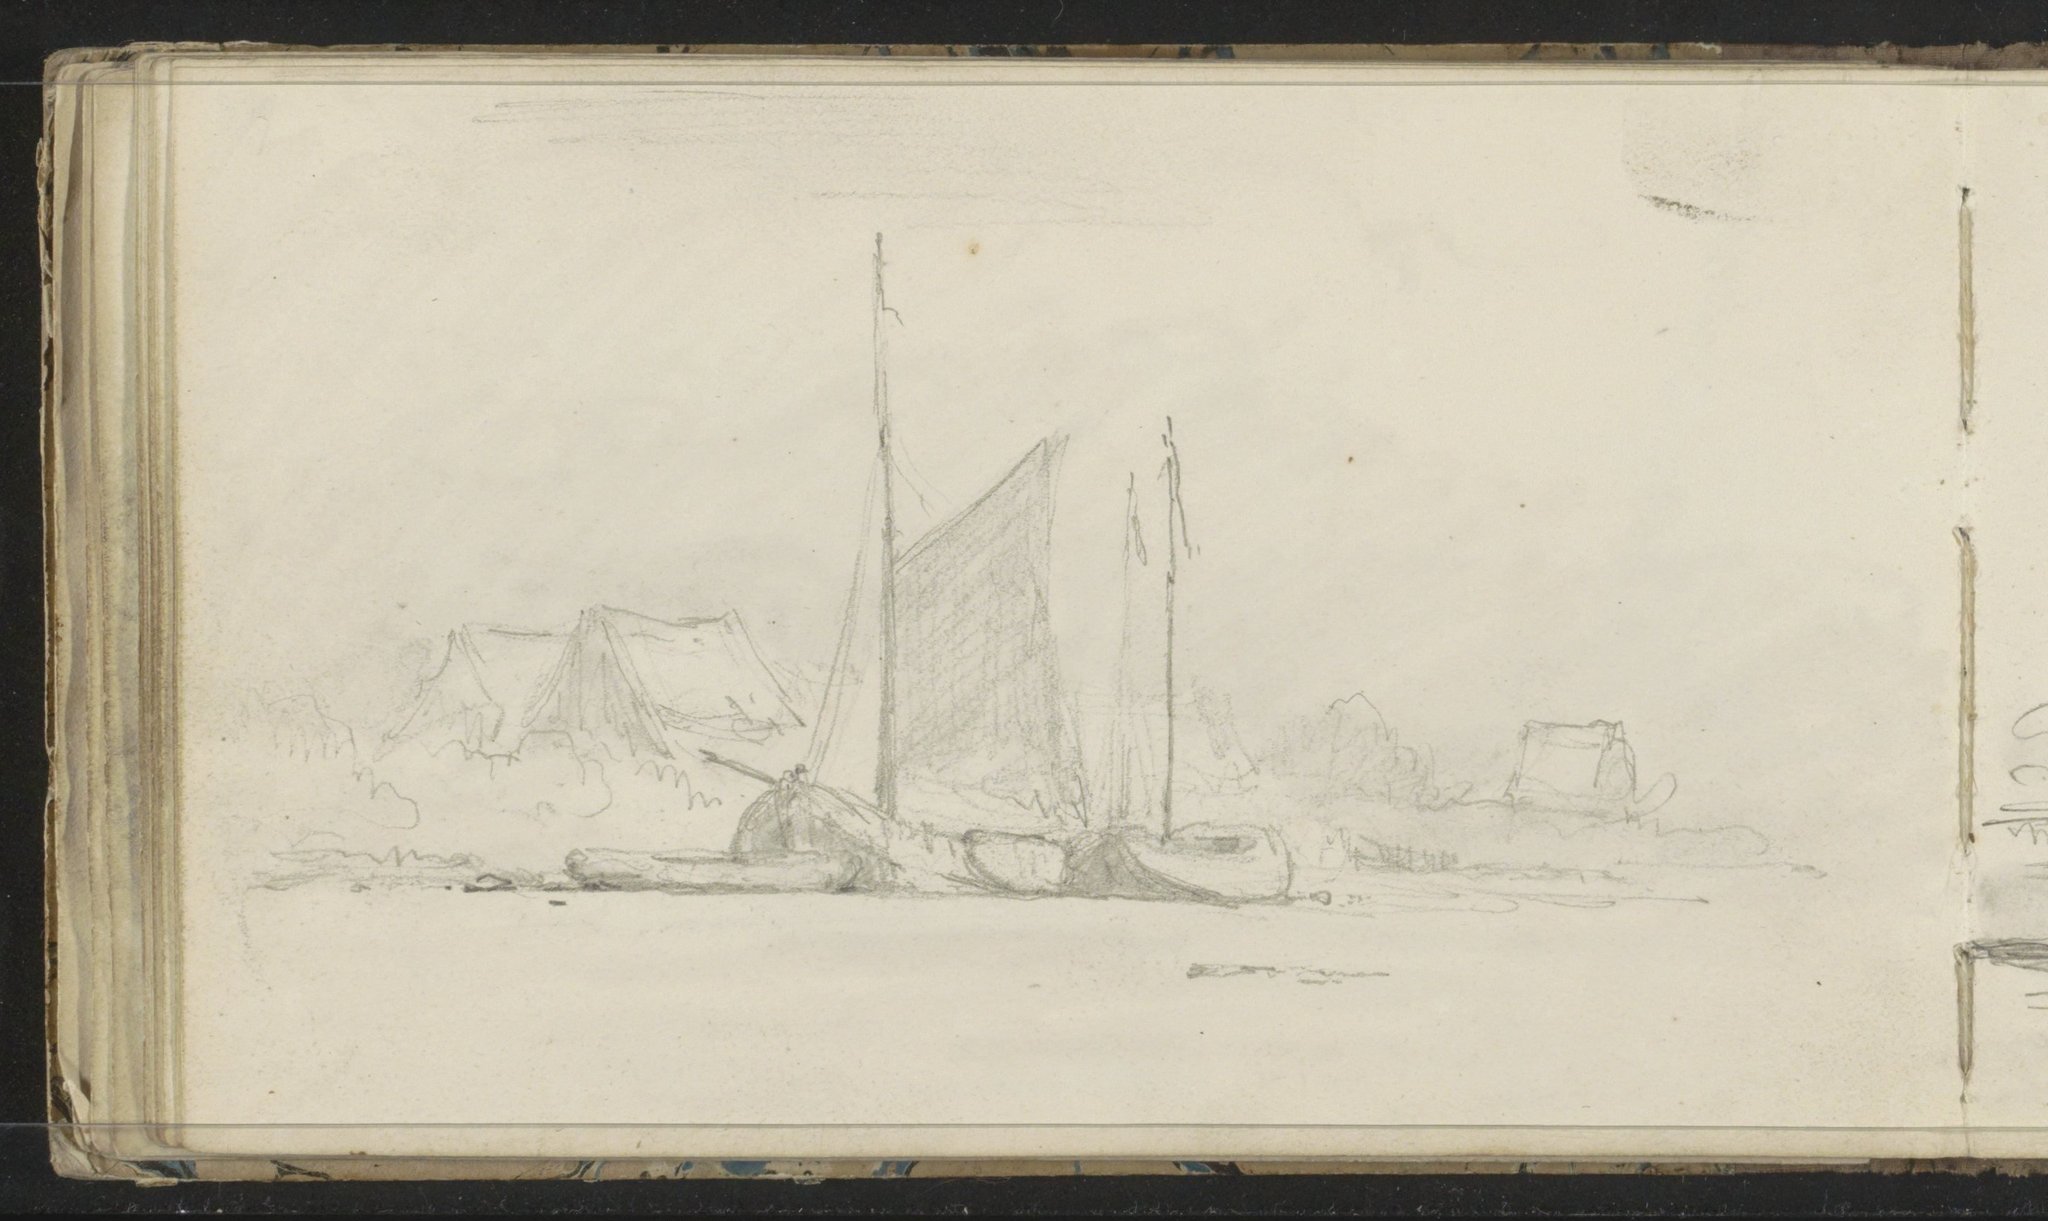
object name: sketchbook leaf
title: Aangemeerde zeilschepen aan een waterkant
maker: arnoldus johannes eymer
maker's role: draughtsman, print maker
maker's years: 1803-1863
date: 1803-1818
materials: paper, pencil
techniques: stumping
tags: city-view, and landscape with man-made constructions, landscapes with waters, waterscapes, seascapes (in the temperate zone), rowing-boat, canoe, etc.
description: Op de achtergrond huizen. Bladzijde 58 uit een schetsboek met 74 bladzijden.